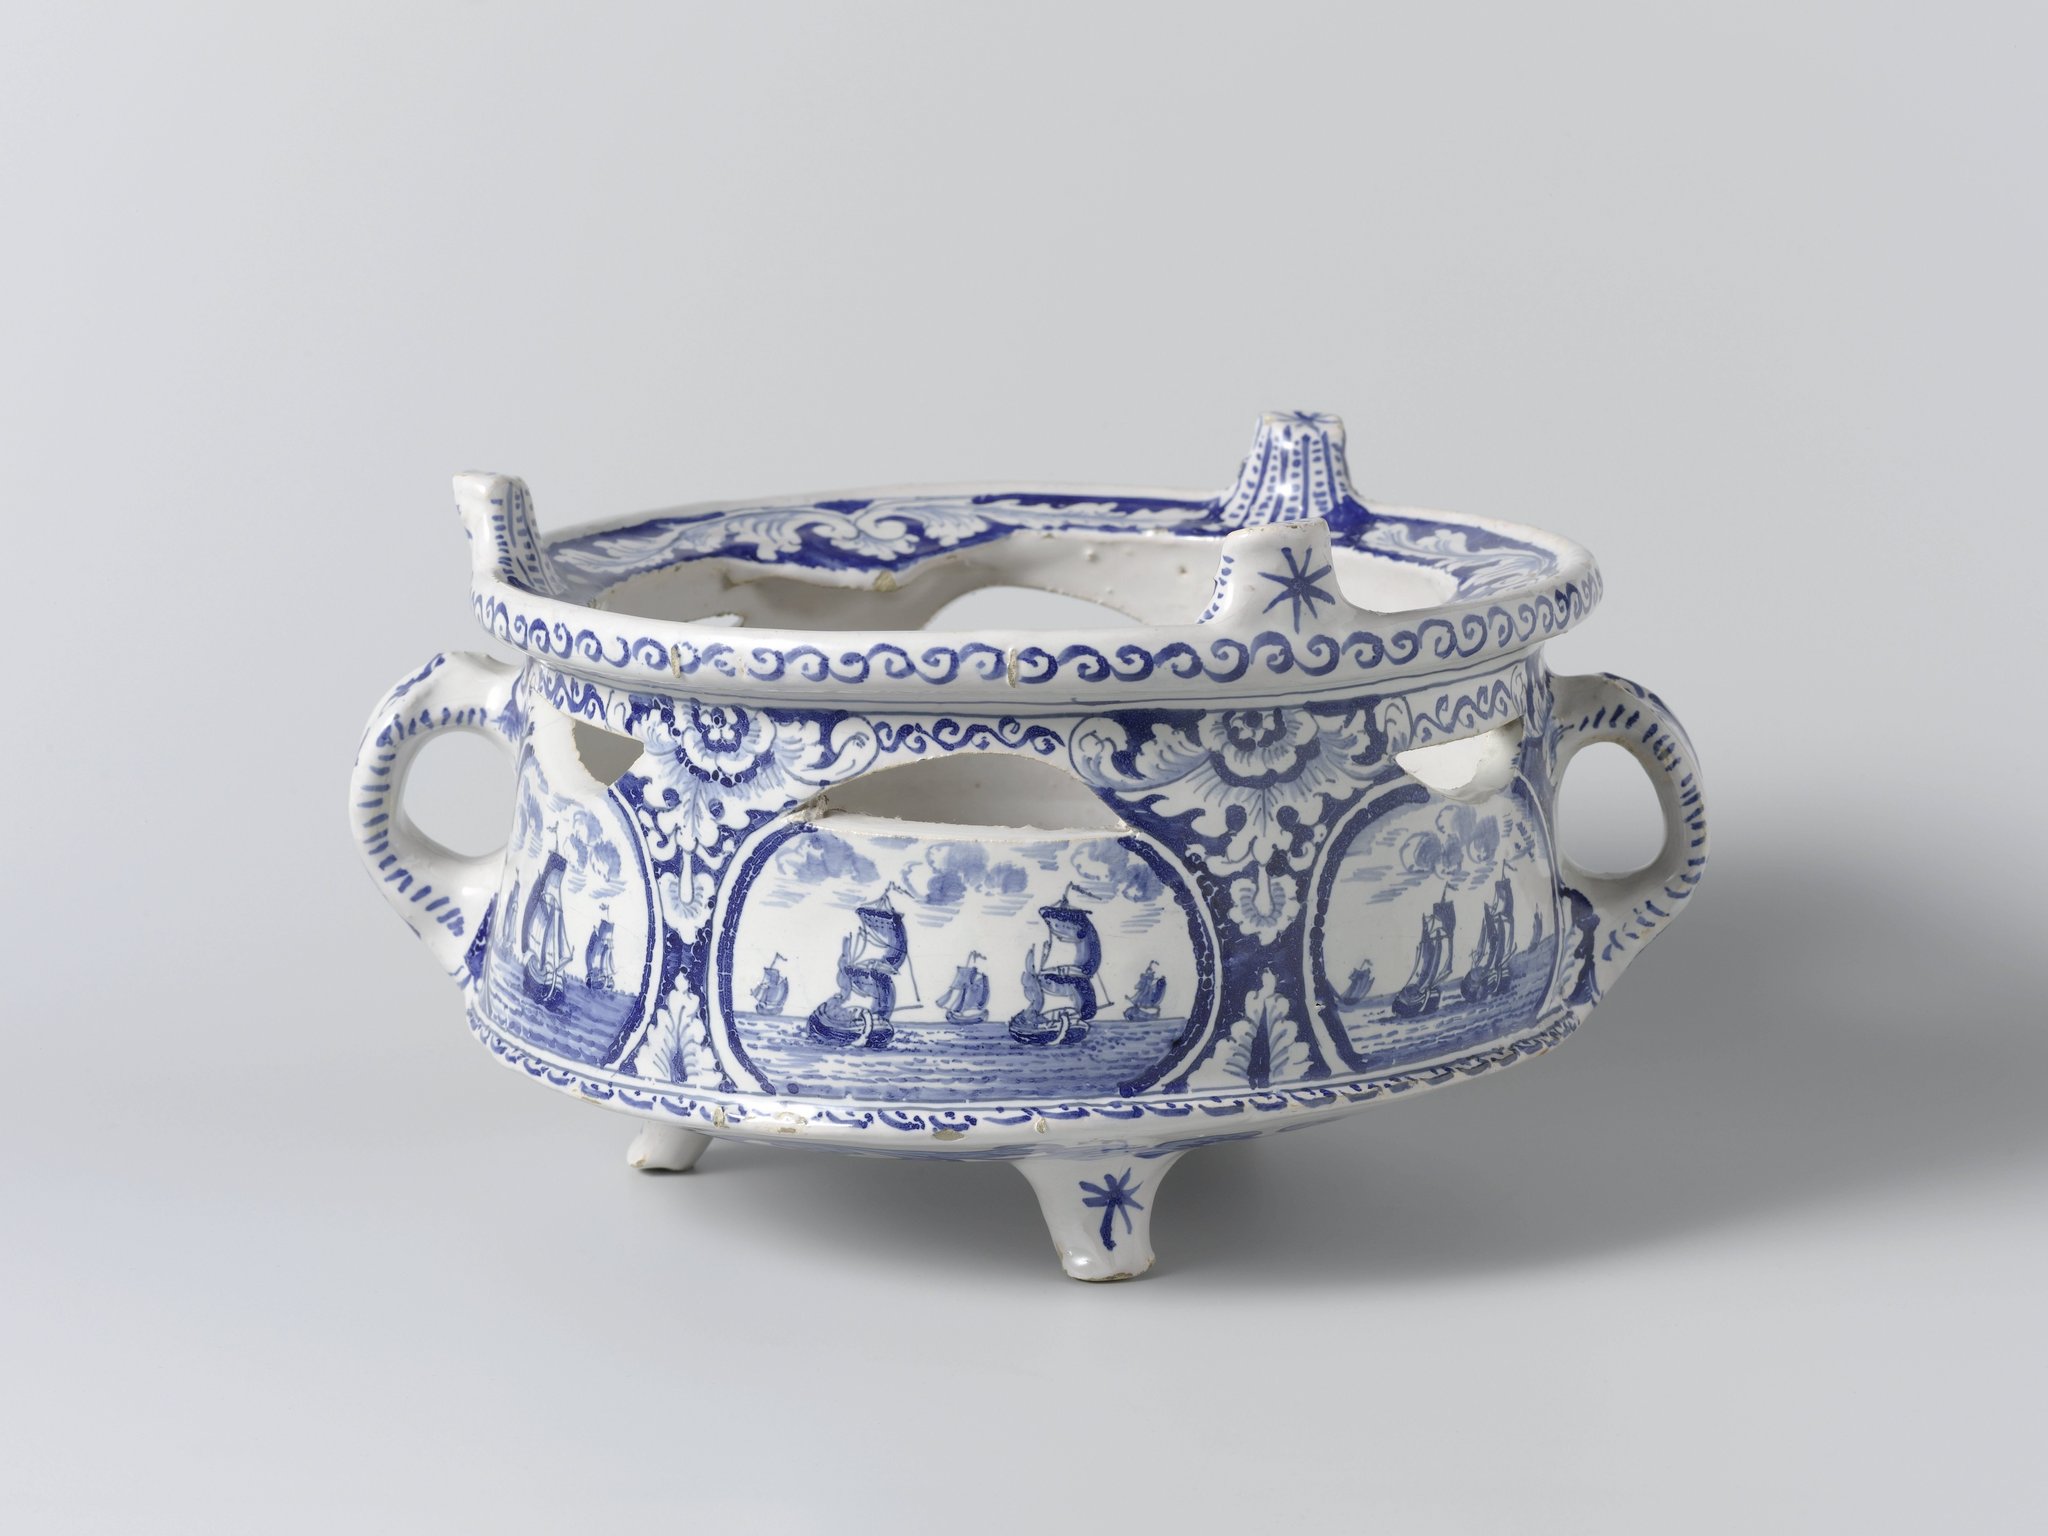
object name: komfoor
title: Komfoor op drie poten en met twee oren. Gedateerd: 1756.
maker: Anonymous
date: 1756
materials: earthenware, glaze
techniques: painted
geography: makkum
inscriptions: date: ‘1756’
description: Rond komfoor van blauw beschilderde faience, op drie poten en met twee oren. Het komfoor heeft een hoge opstaande wand met een rand waarop drie liggende en drie staande steunen. De wand heeft half-cirkelvormige openingen en is beschilderd met zes vakken waarbinnen zeegezichten met schepen. Het komfoor is gedateerd: 1756.